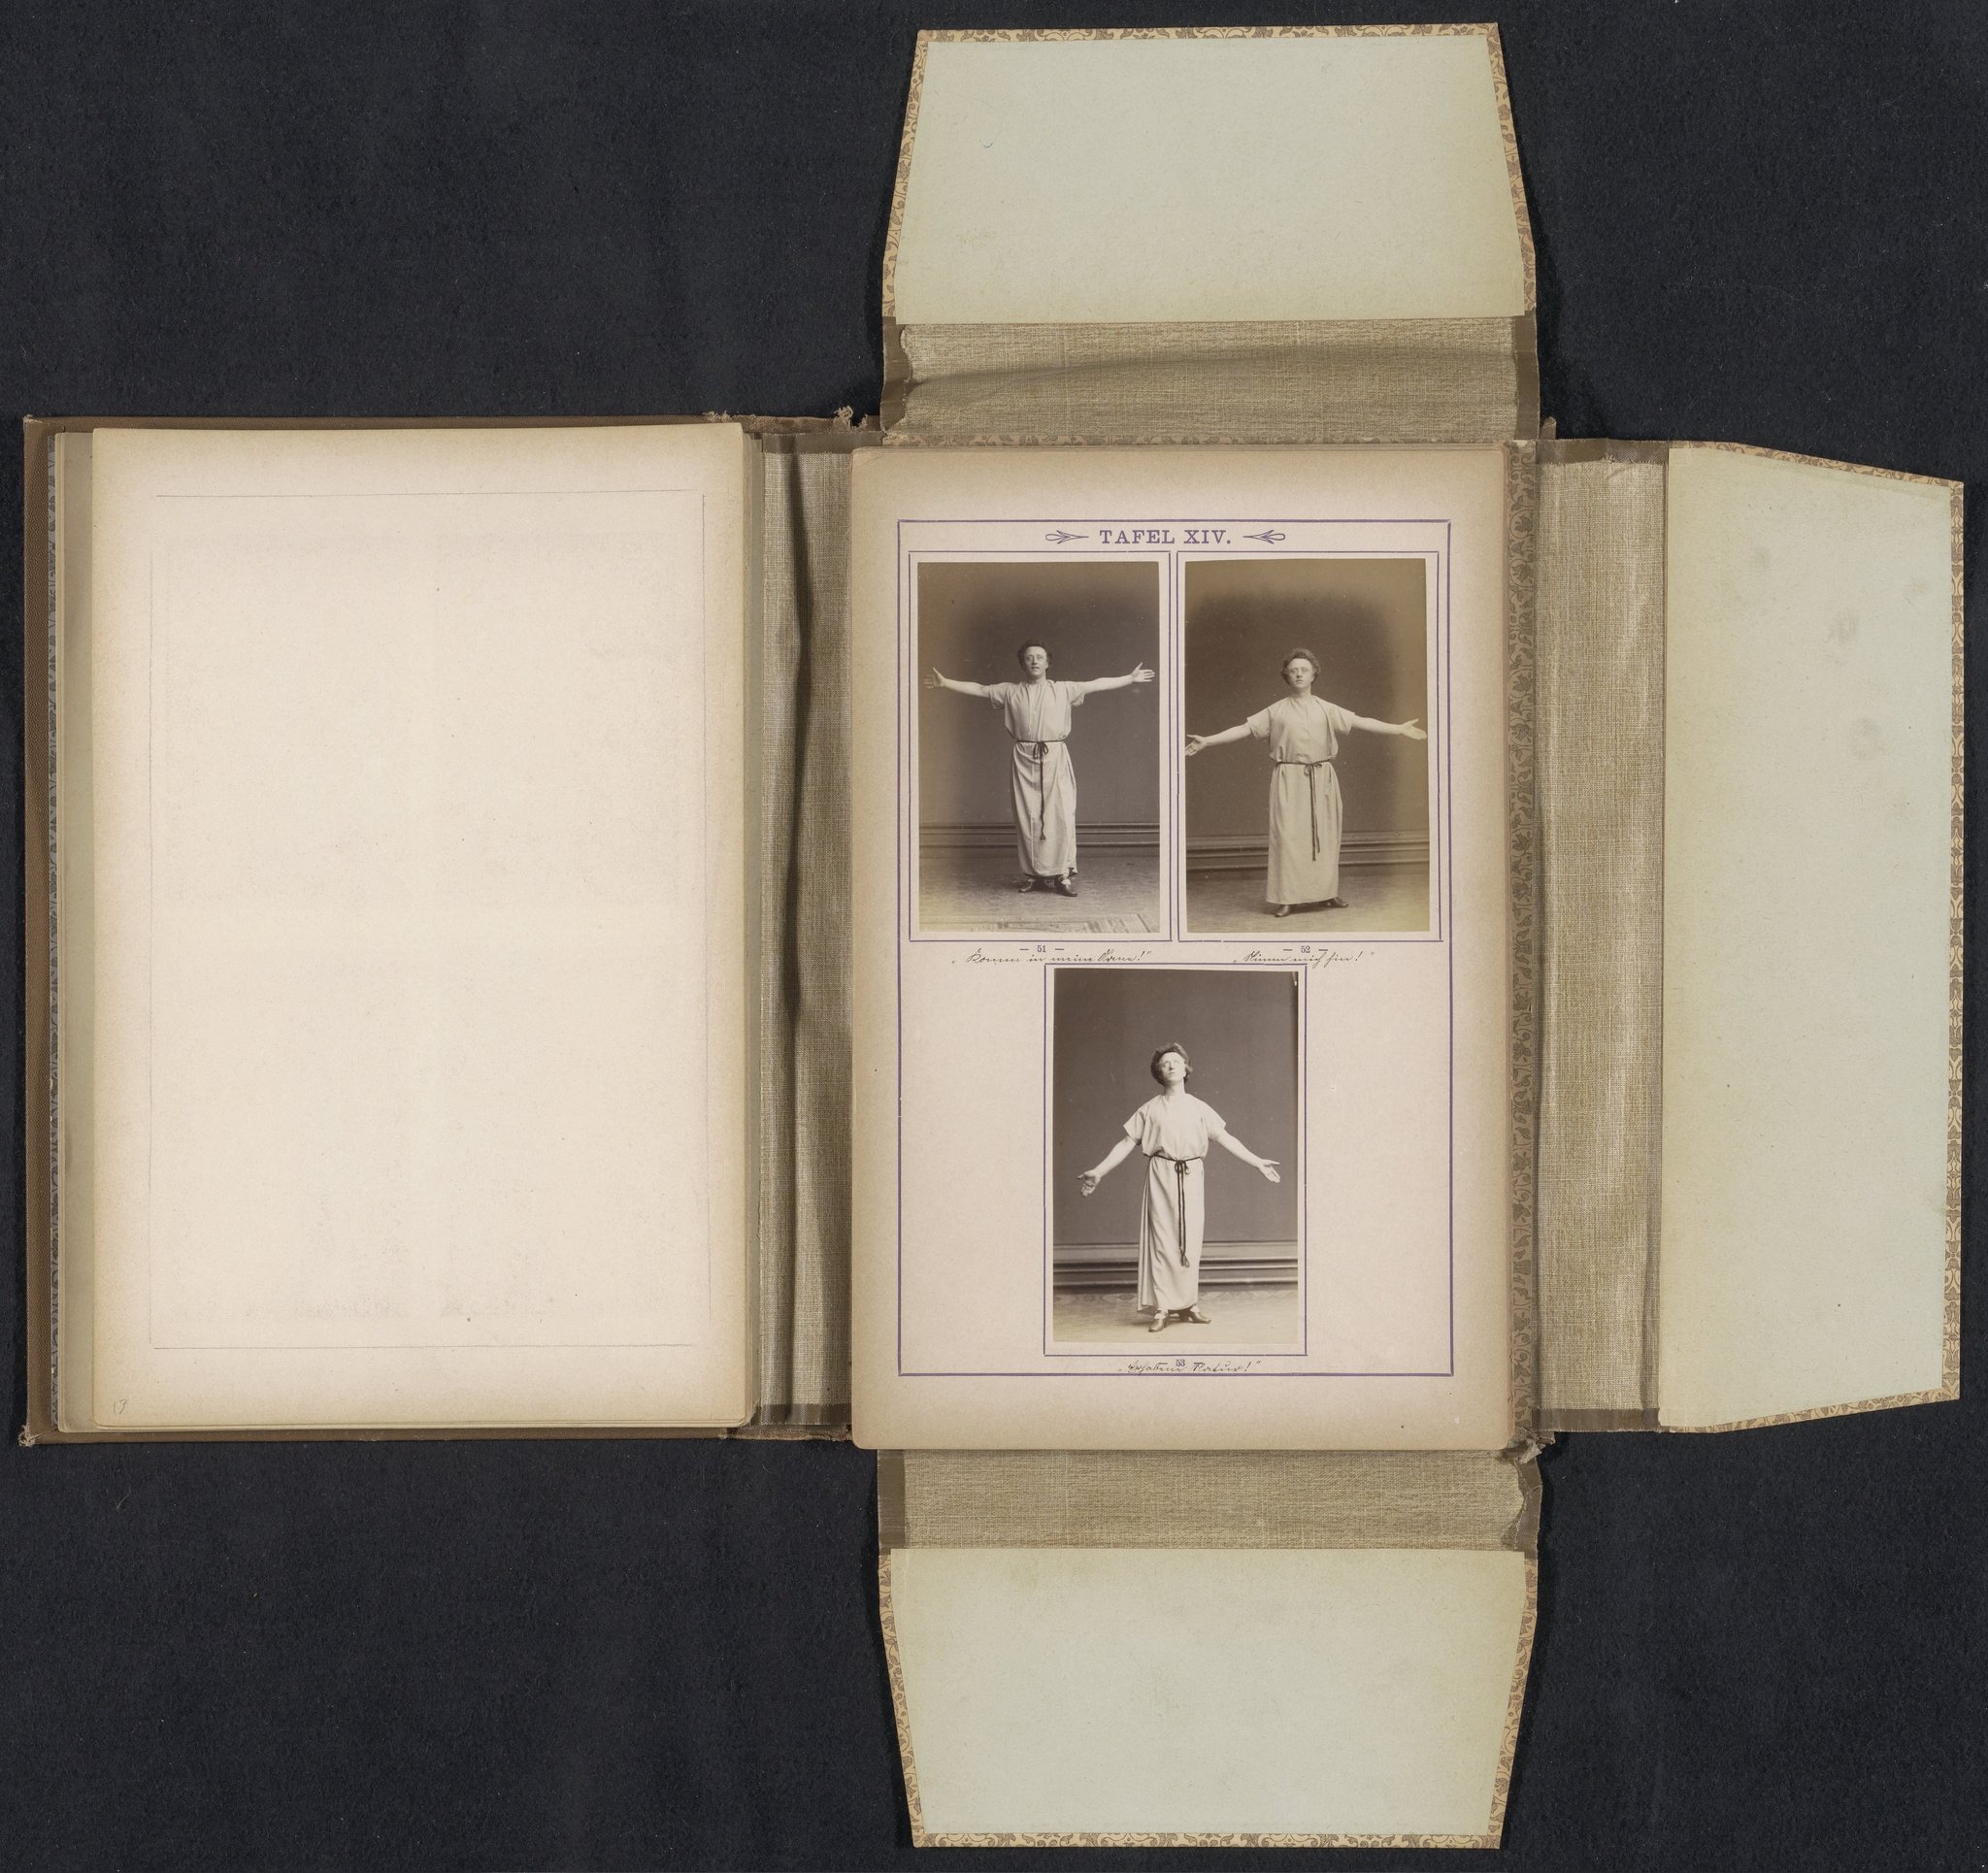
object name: album leaf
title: Portretten van een man in drie poses met zijdelings gestrekte armen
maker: nicola tonger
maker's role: fotograaf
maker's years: 1846-1917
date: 1881-1886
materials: cardboard, photographic support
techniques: albumen print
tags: gesture-language, arm stretched sidewards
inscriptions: inscription: ‘,,Komm in (...) Natur!''’, number: ‘Tafel XIV.’, number: ‘51 (...) 53’